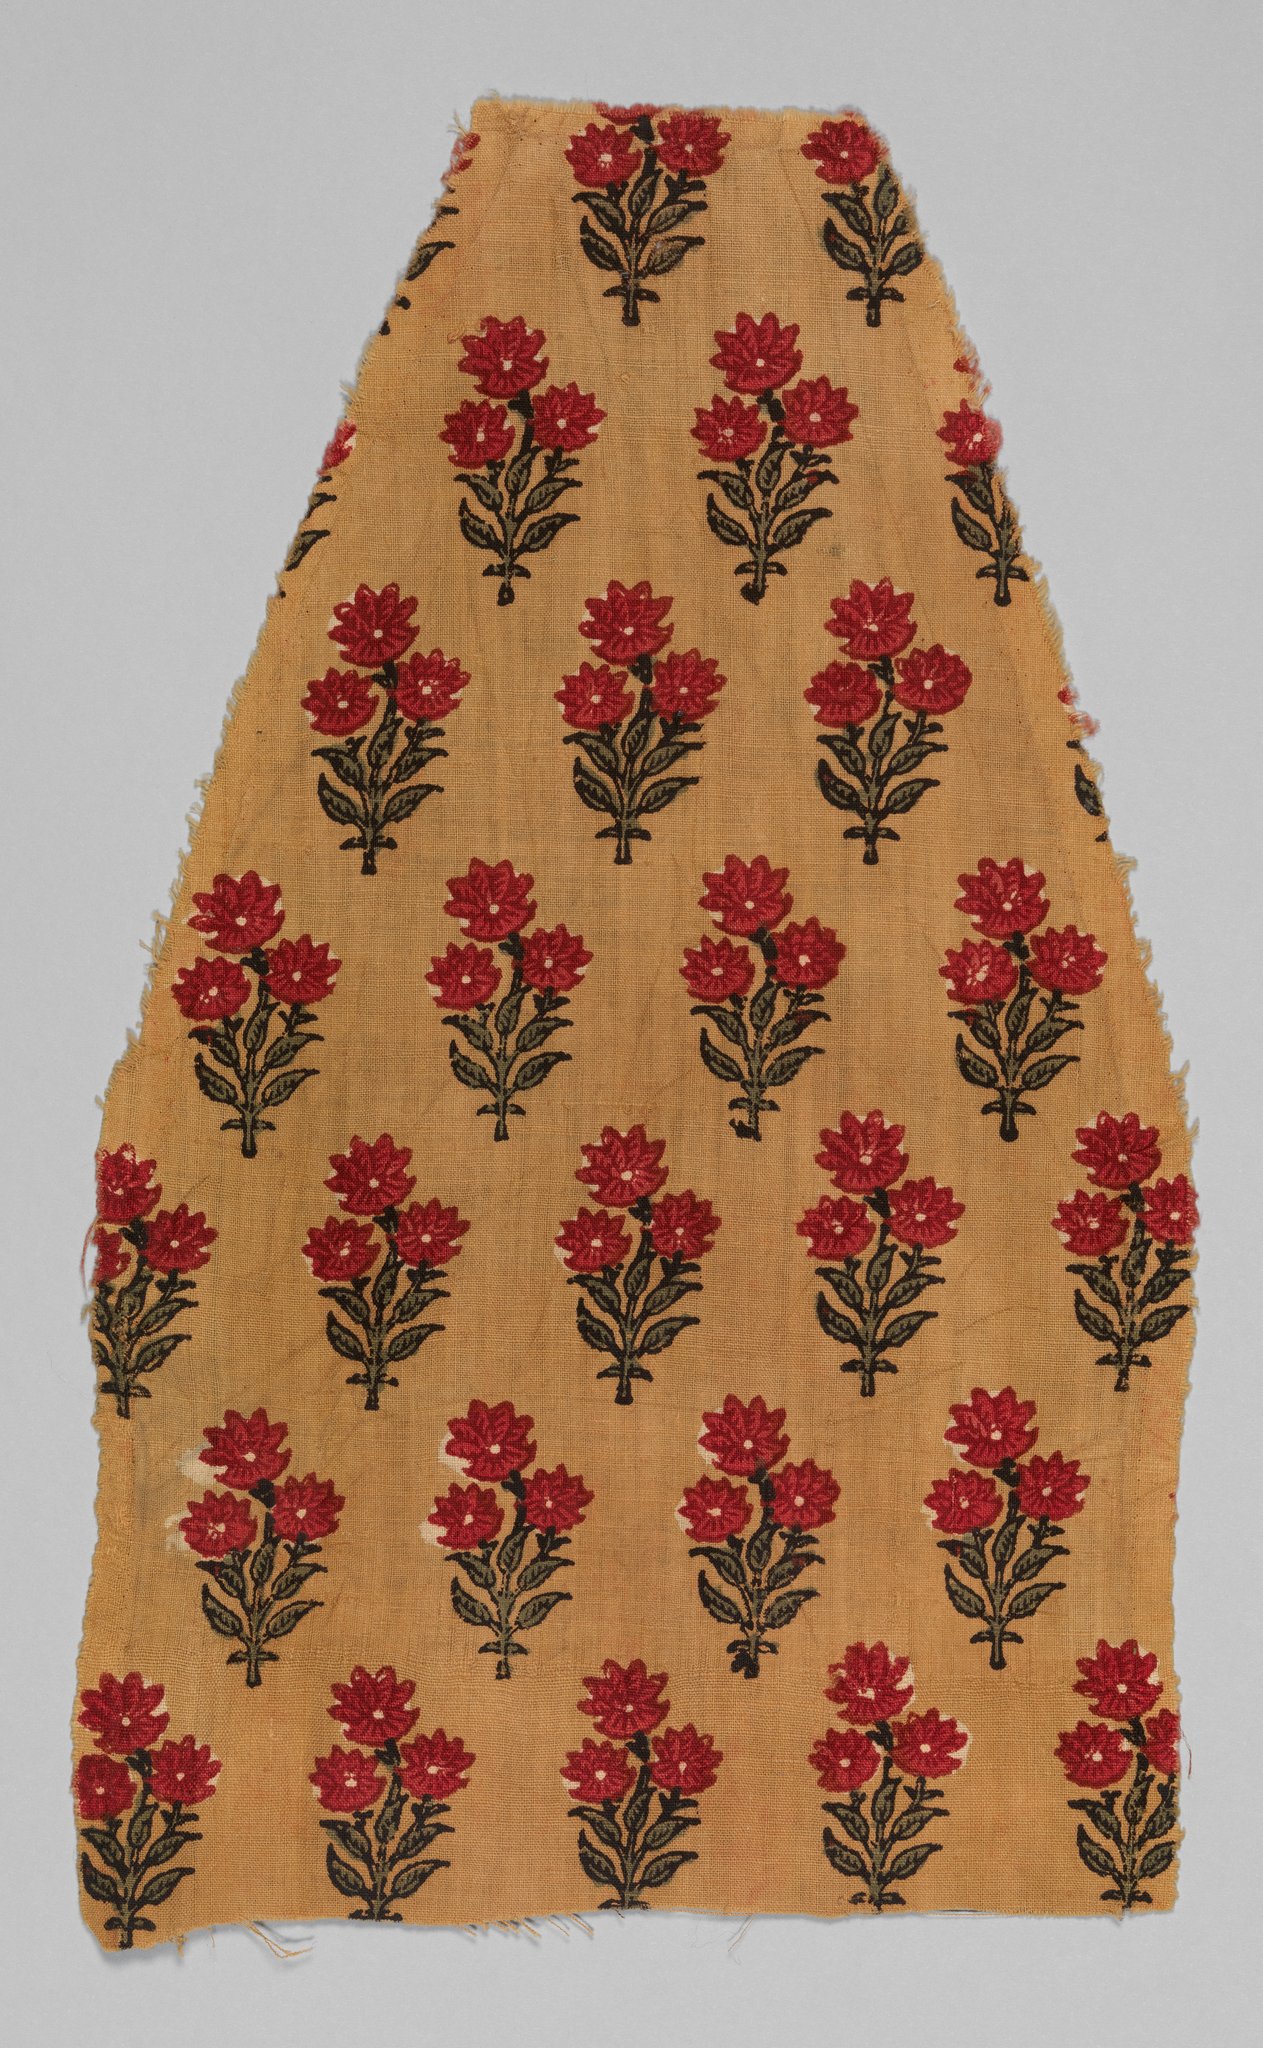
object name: textile fragment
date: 1801-1900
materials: cotton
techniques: printing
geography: india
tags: flowers